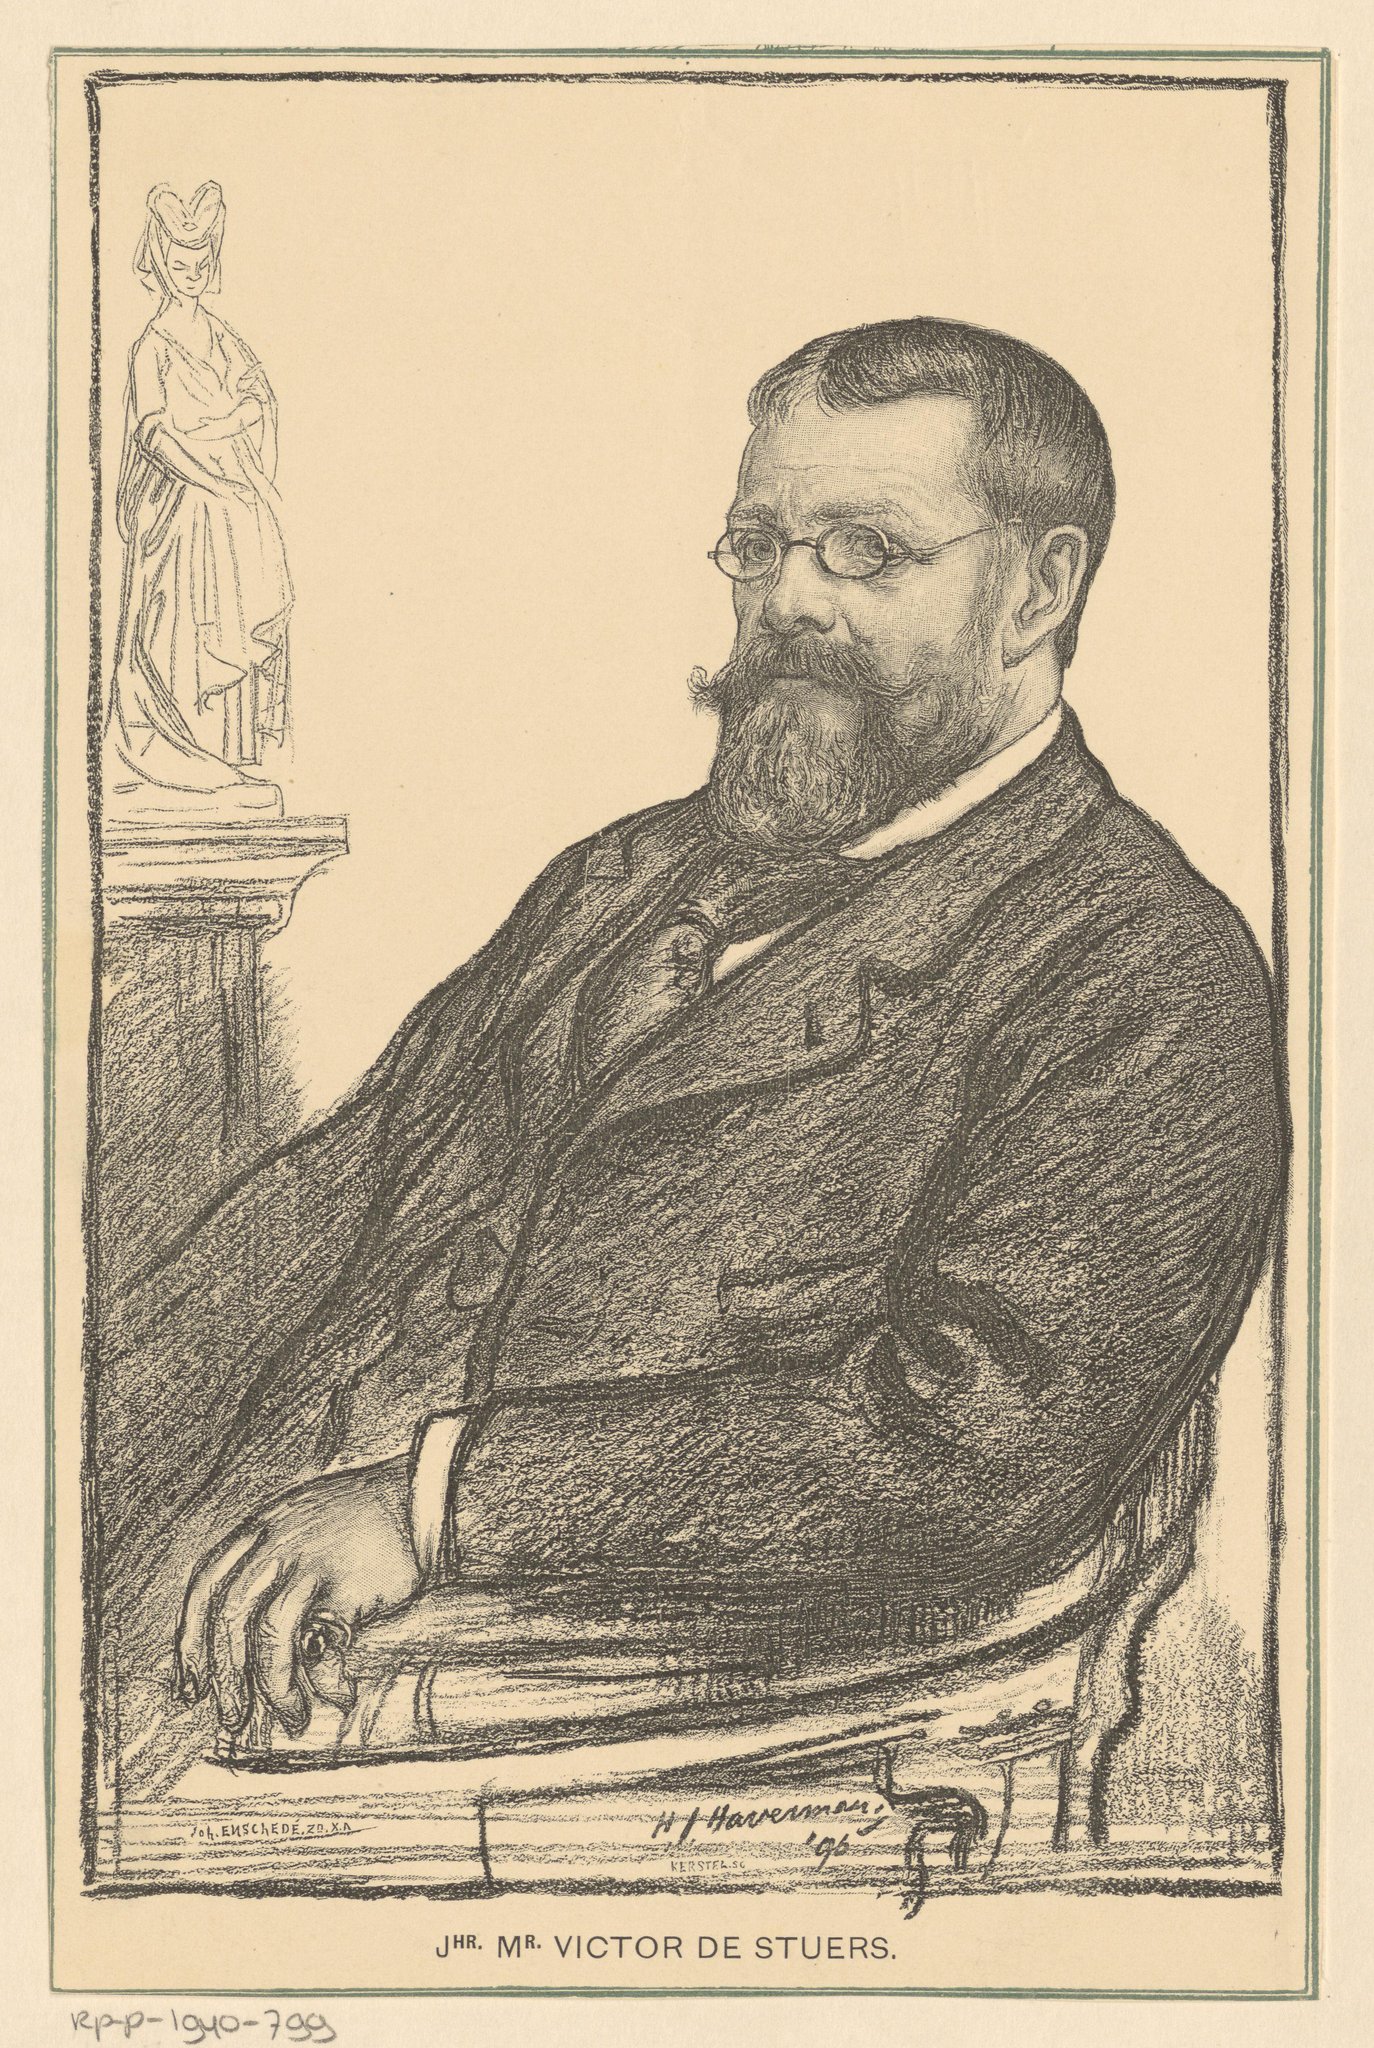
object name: print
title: Portret van Victor de Stuers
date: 1896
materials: paper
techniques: lithograph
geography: netherlands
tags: maastricht, the hague, politician, victor de stuers, historical persons, politician, e.g. party leader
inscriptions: collector's mark: Lugt 2228, collector's mark: Lugt 2760